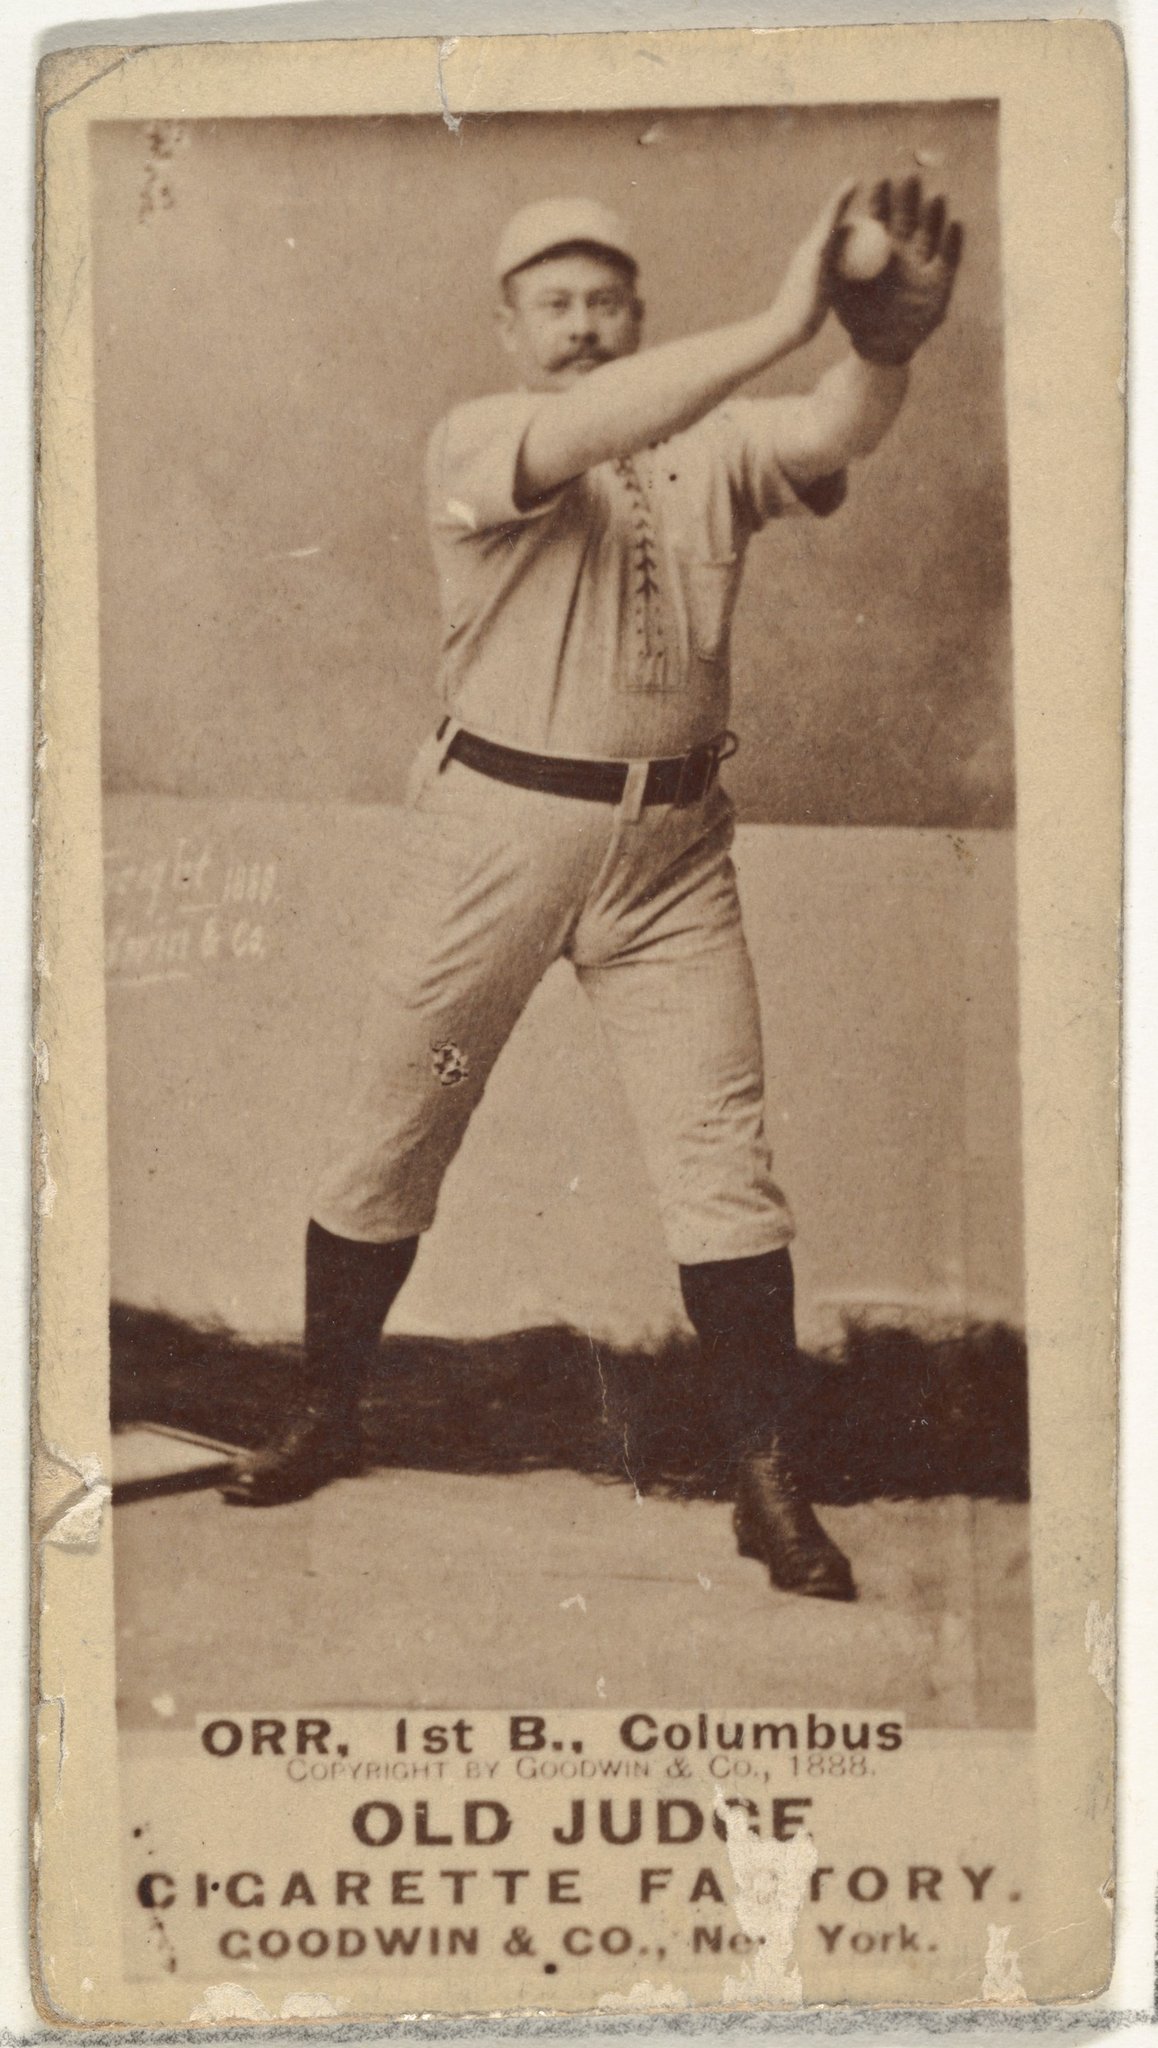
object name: baseball card, photograph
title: David L. "Dave" Orr, 1st Base, Cleveland, from the Old Judge series (N172) for Old Judge Cigarettes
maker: goodwin & company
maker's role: publisher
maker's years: 1850-1950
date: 1888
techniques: albumen silver print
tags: men,baseball,athletes